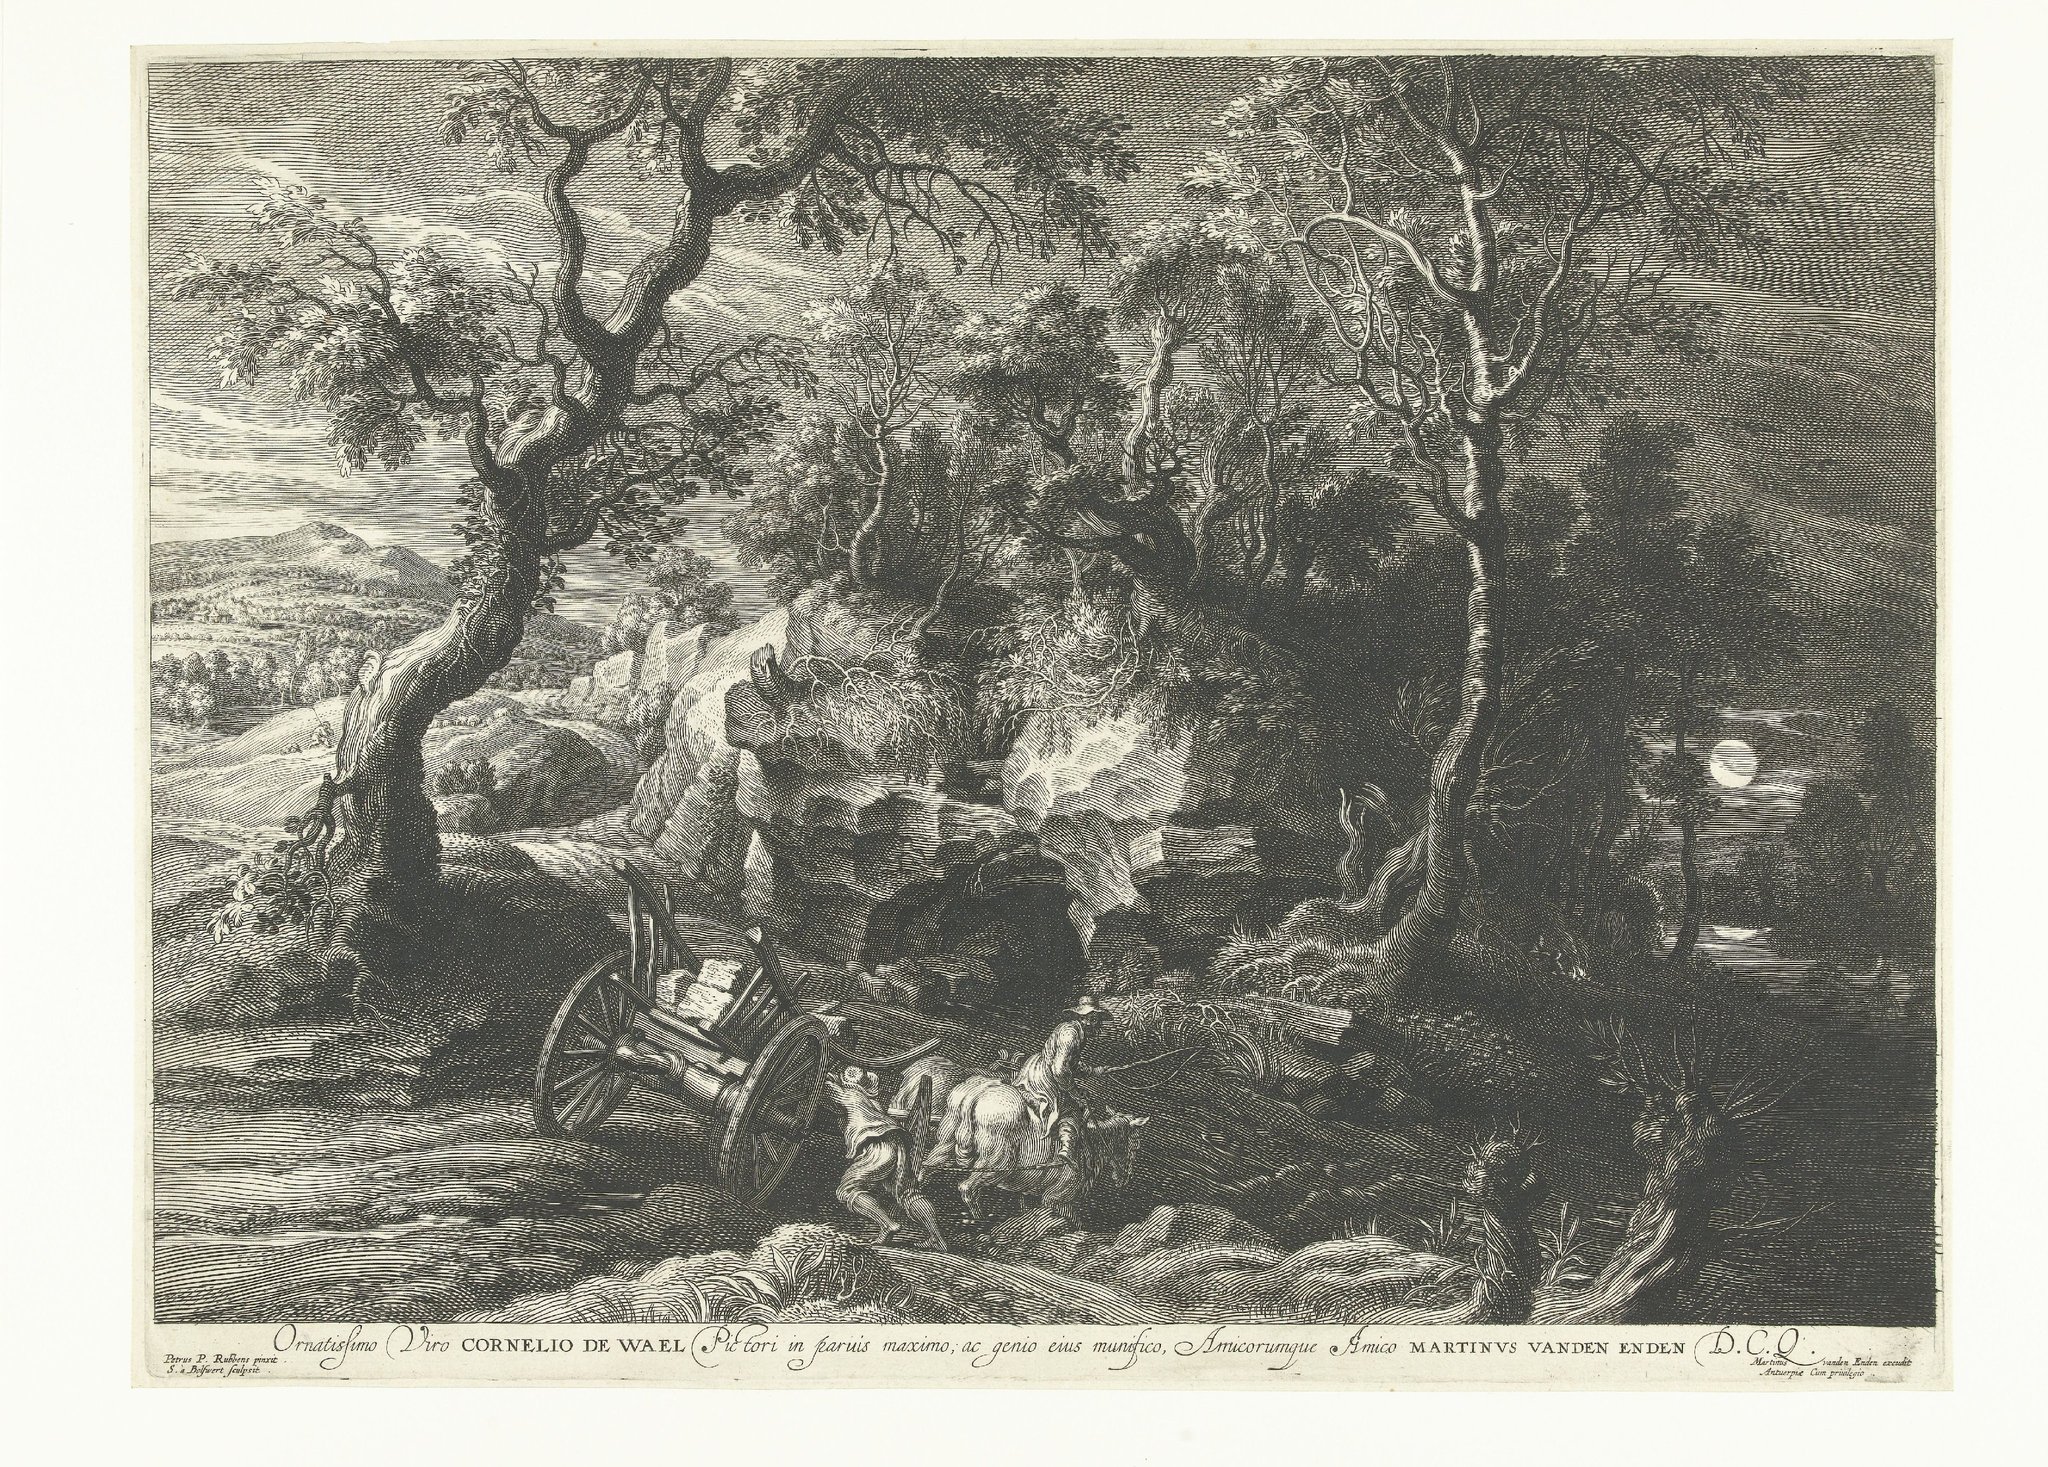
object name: print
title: Landschap met vastgelopen wagen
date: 1596-1659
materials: paper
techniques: engraving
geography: antwerp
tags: low hill country, moonlight, accident with animal-drawn vehicle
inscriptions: collector's mark: Lugt 240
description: Prent naar schilderij van Peter Paul Rubens. Hollstein beschrijft een serie kleine landschappen onder de nrs. 305 t/m 325 maar deze prenten zijn niet als reeks vervaardigd.